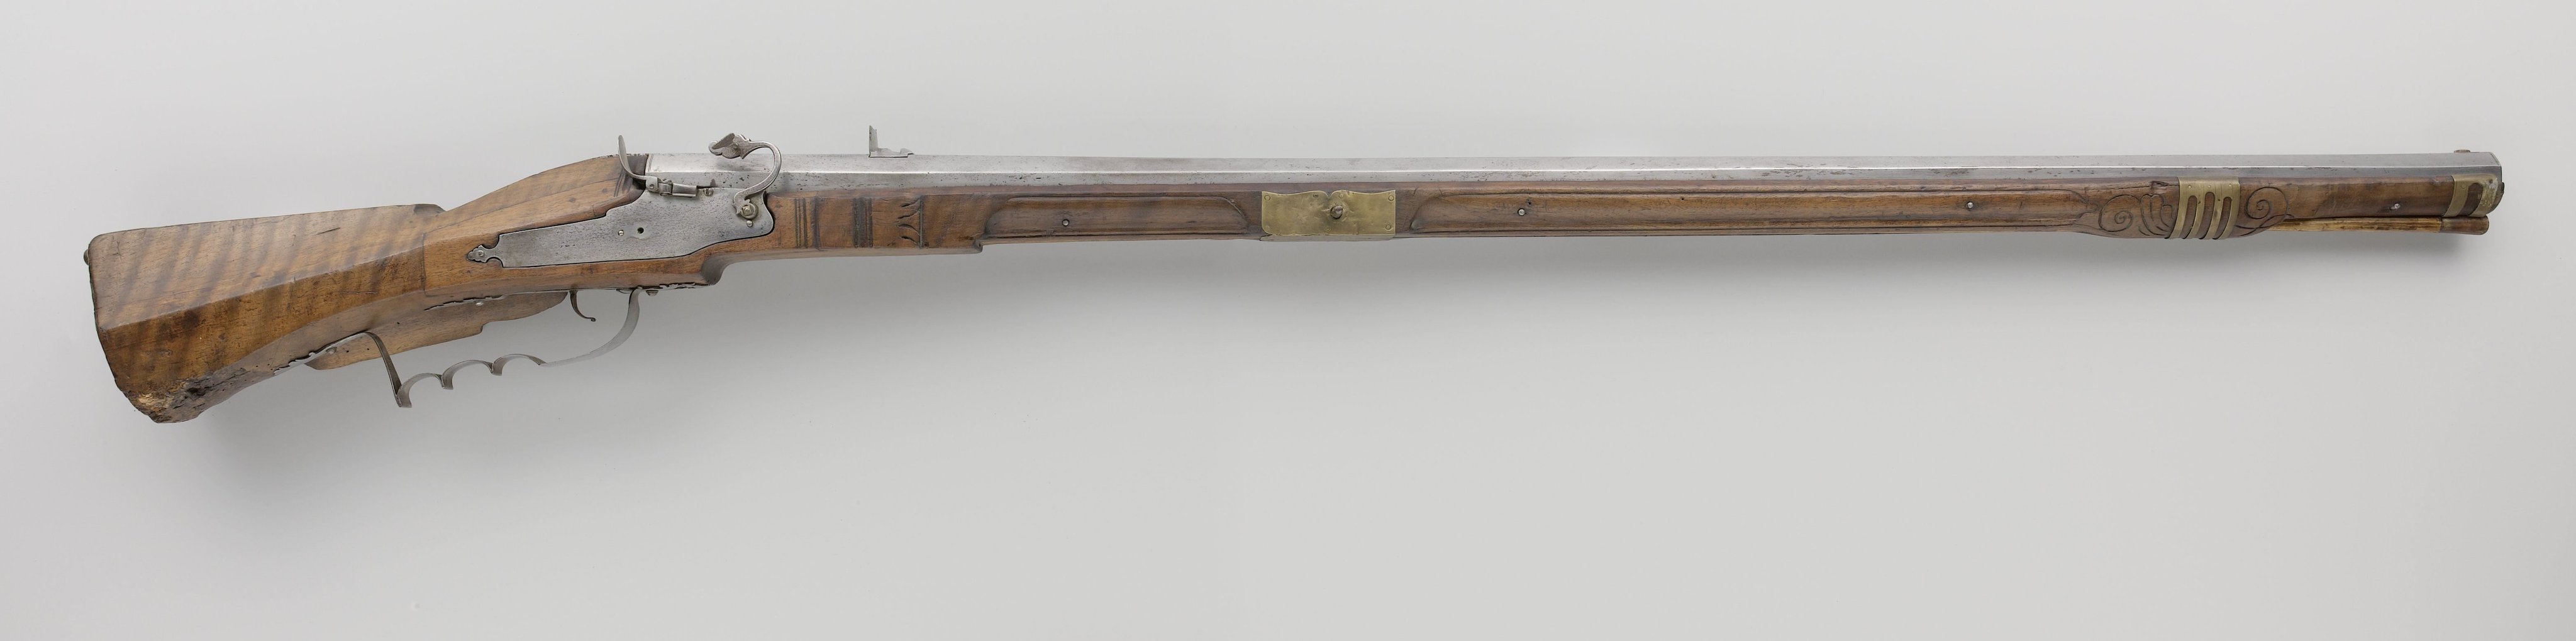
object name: musketoon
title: Walbuks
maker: Anonymous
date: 1499-1699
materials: copper, iron, wood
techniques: embroidery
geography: netherlands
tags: netherlands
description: Walbuks met achthoekige getrokken loop. De lade is van hout en is bewerkt met ingesneden krulmotieven. Aan het uiteinde van de lade een koperen ladeband. Halverwege de loop een vierkante koperen ladeband waartussen aan weerzijden een ijzeren pin doorheem steekt. Het platte slot is van ijzer waaraan de lonthouder en de pan die zijwaarts geopend kan worden aan bevestigd zitten, de lonthouder is met een koperen schroefje gefixeerd, aan de andere zijde van het slot bevinden zich twee ijzeren aandraaischroeven. De kolf is van hout en heeft een koperen kolfkap welke met een ijzeren ronde pin zit bevestigd. De trekkerbeugel is van ijzer en is gekromd voor de greep van de hand van de drager. De trekker zit bevestigd aan ajour beslag met gekrulde motieven. Onder de lade een houten laadstok welke een andere kleur heeft dan de walbuks. Op de loop zit een ijzeren vizierkeep.